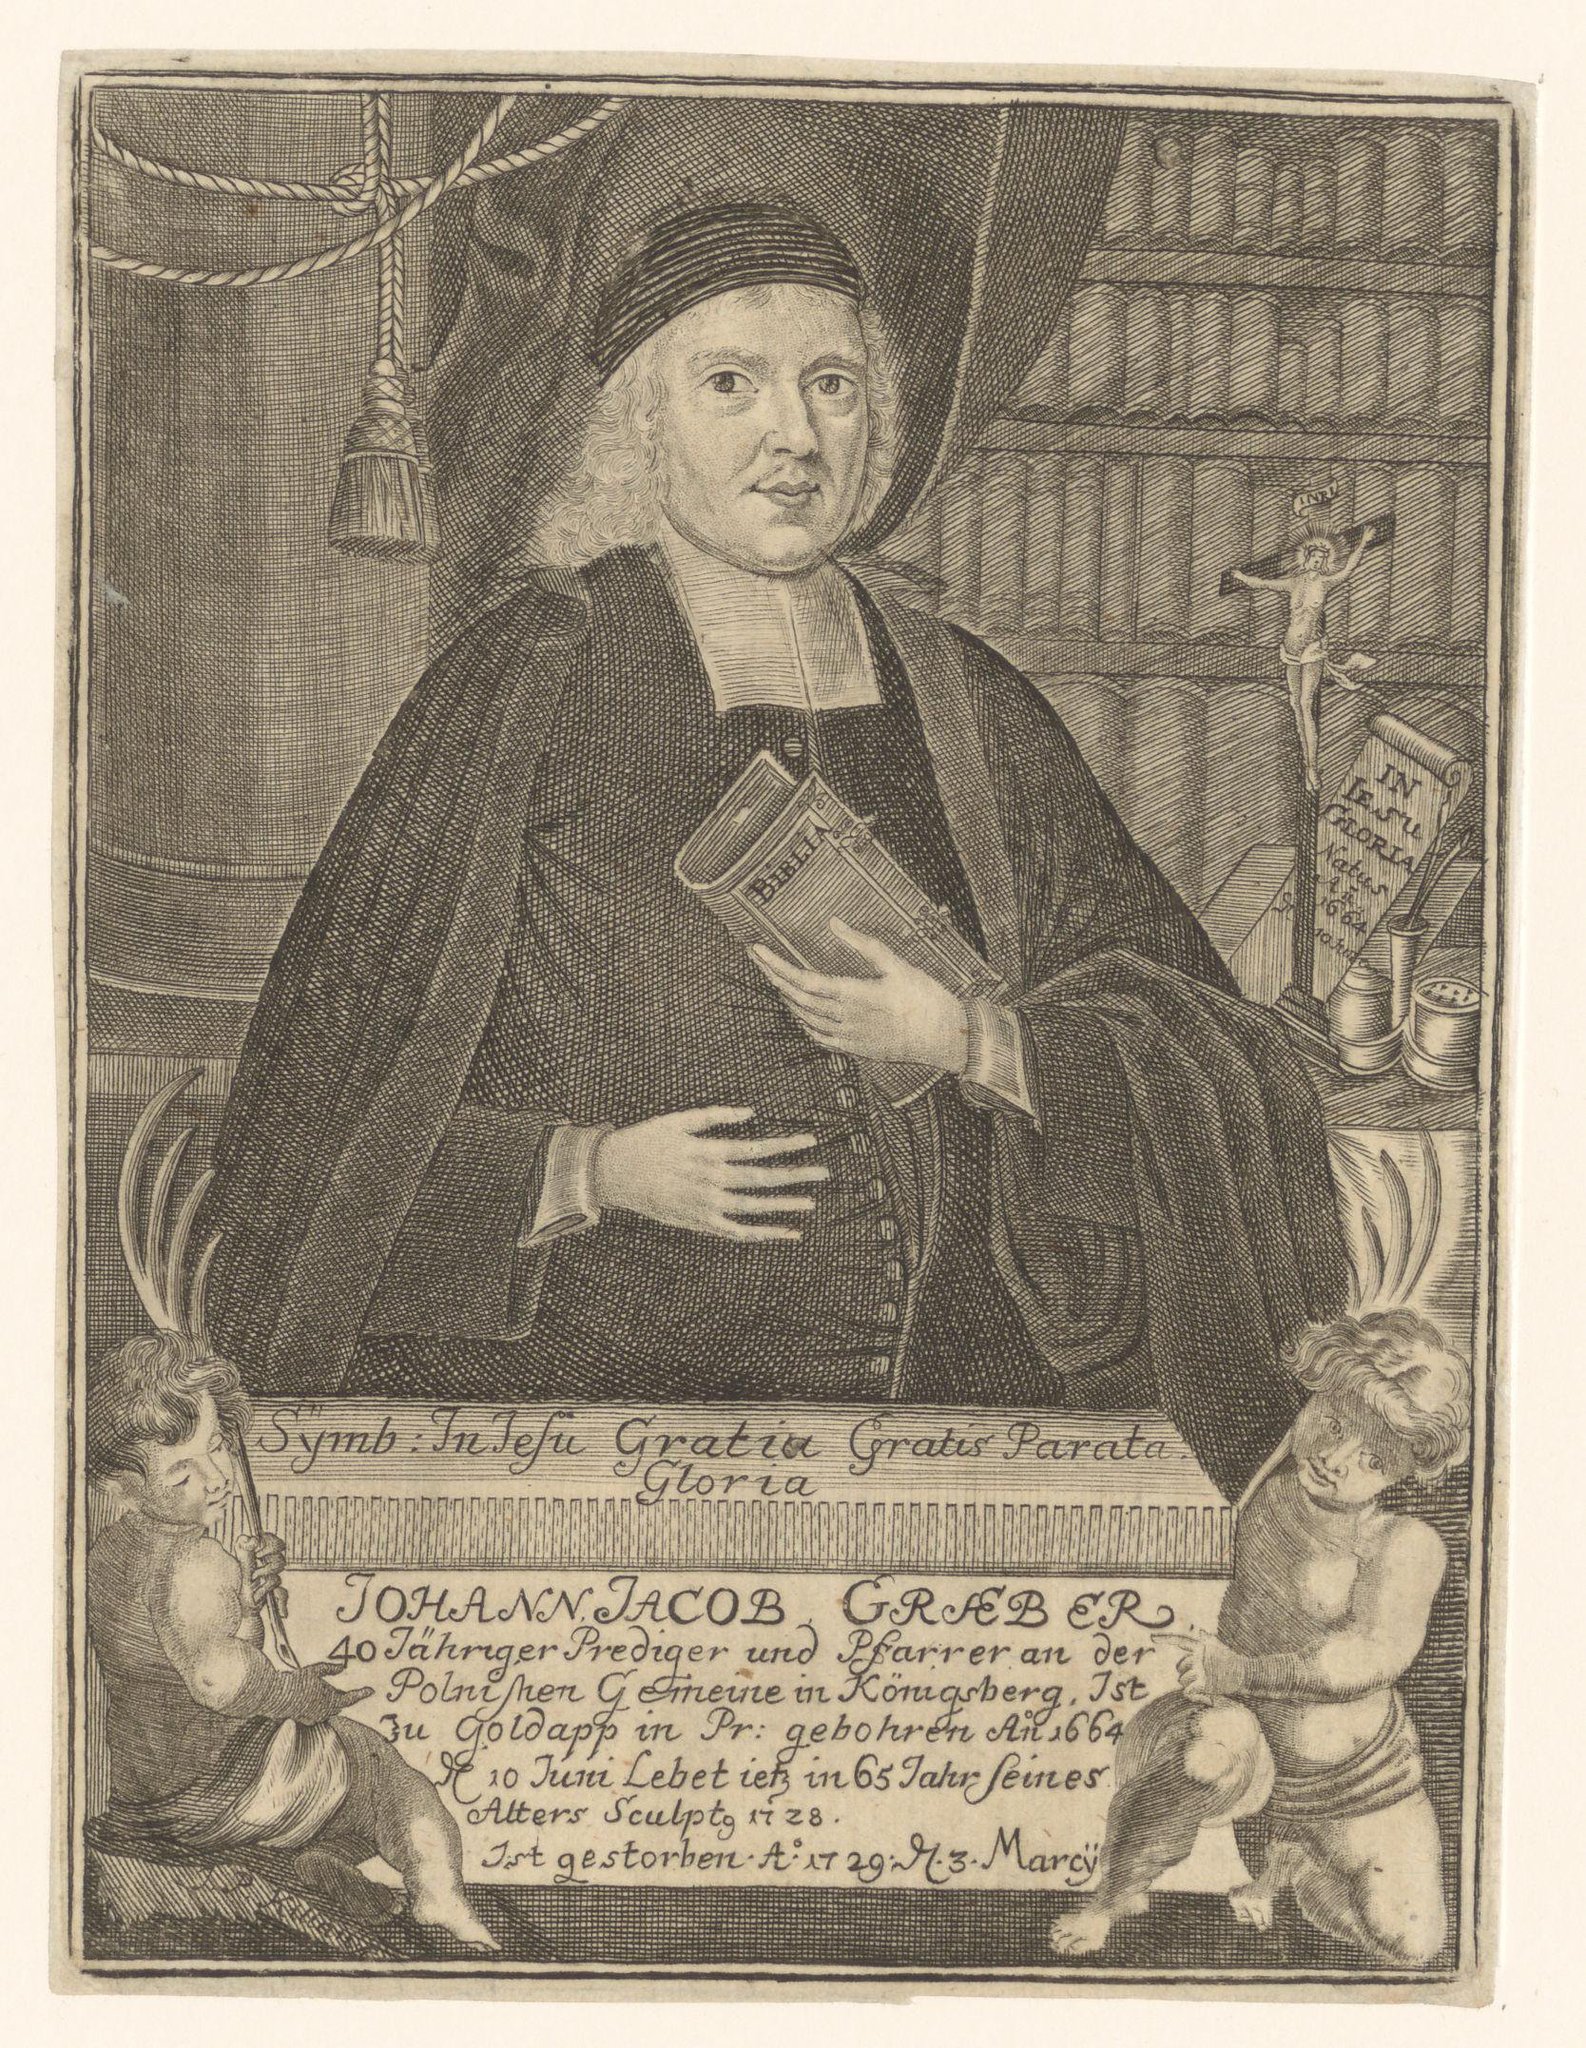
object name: print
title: Portret van Johann Jacob Graeber op 65-jarige leeftijd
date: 1729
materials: paper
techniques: engraving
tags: theologian, historical persons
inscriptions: collector's mark: Lugt 2228